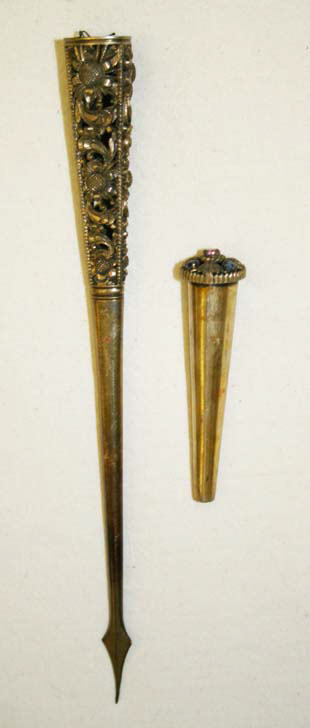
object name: hairpin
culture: sri lankan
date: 1801-1900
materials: silver